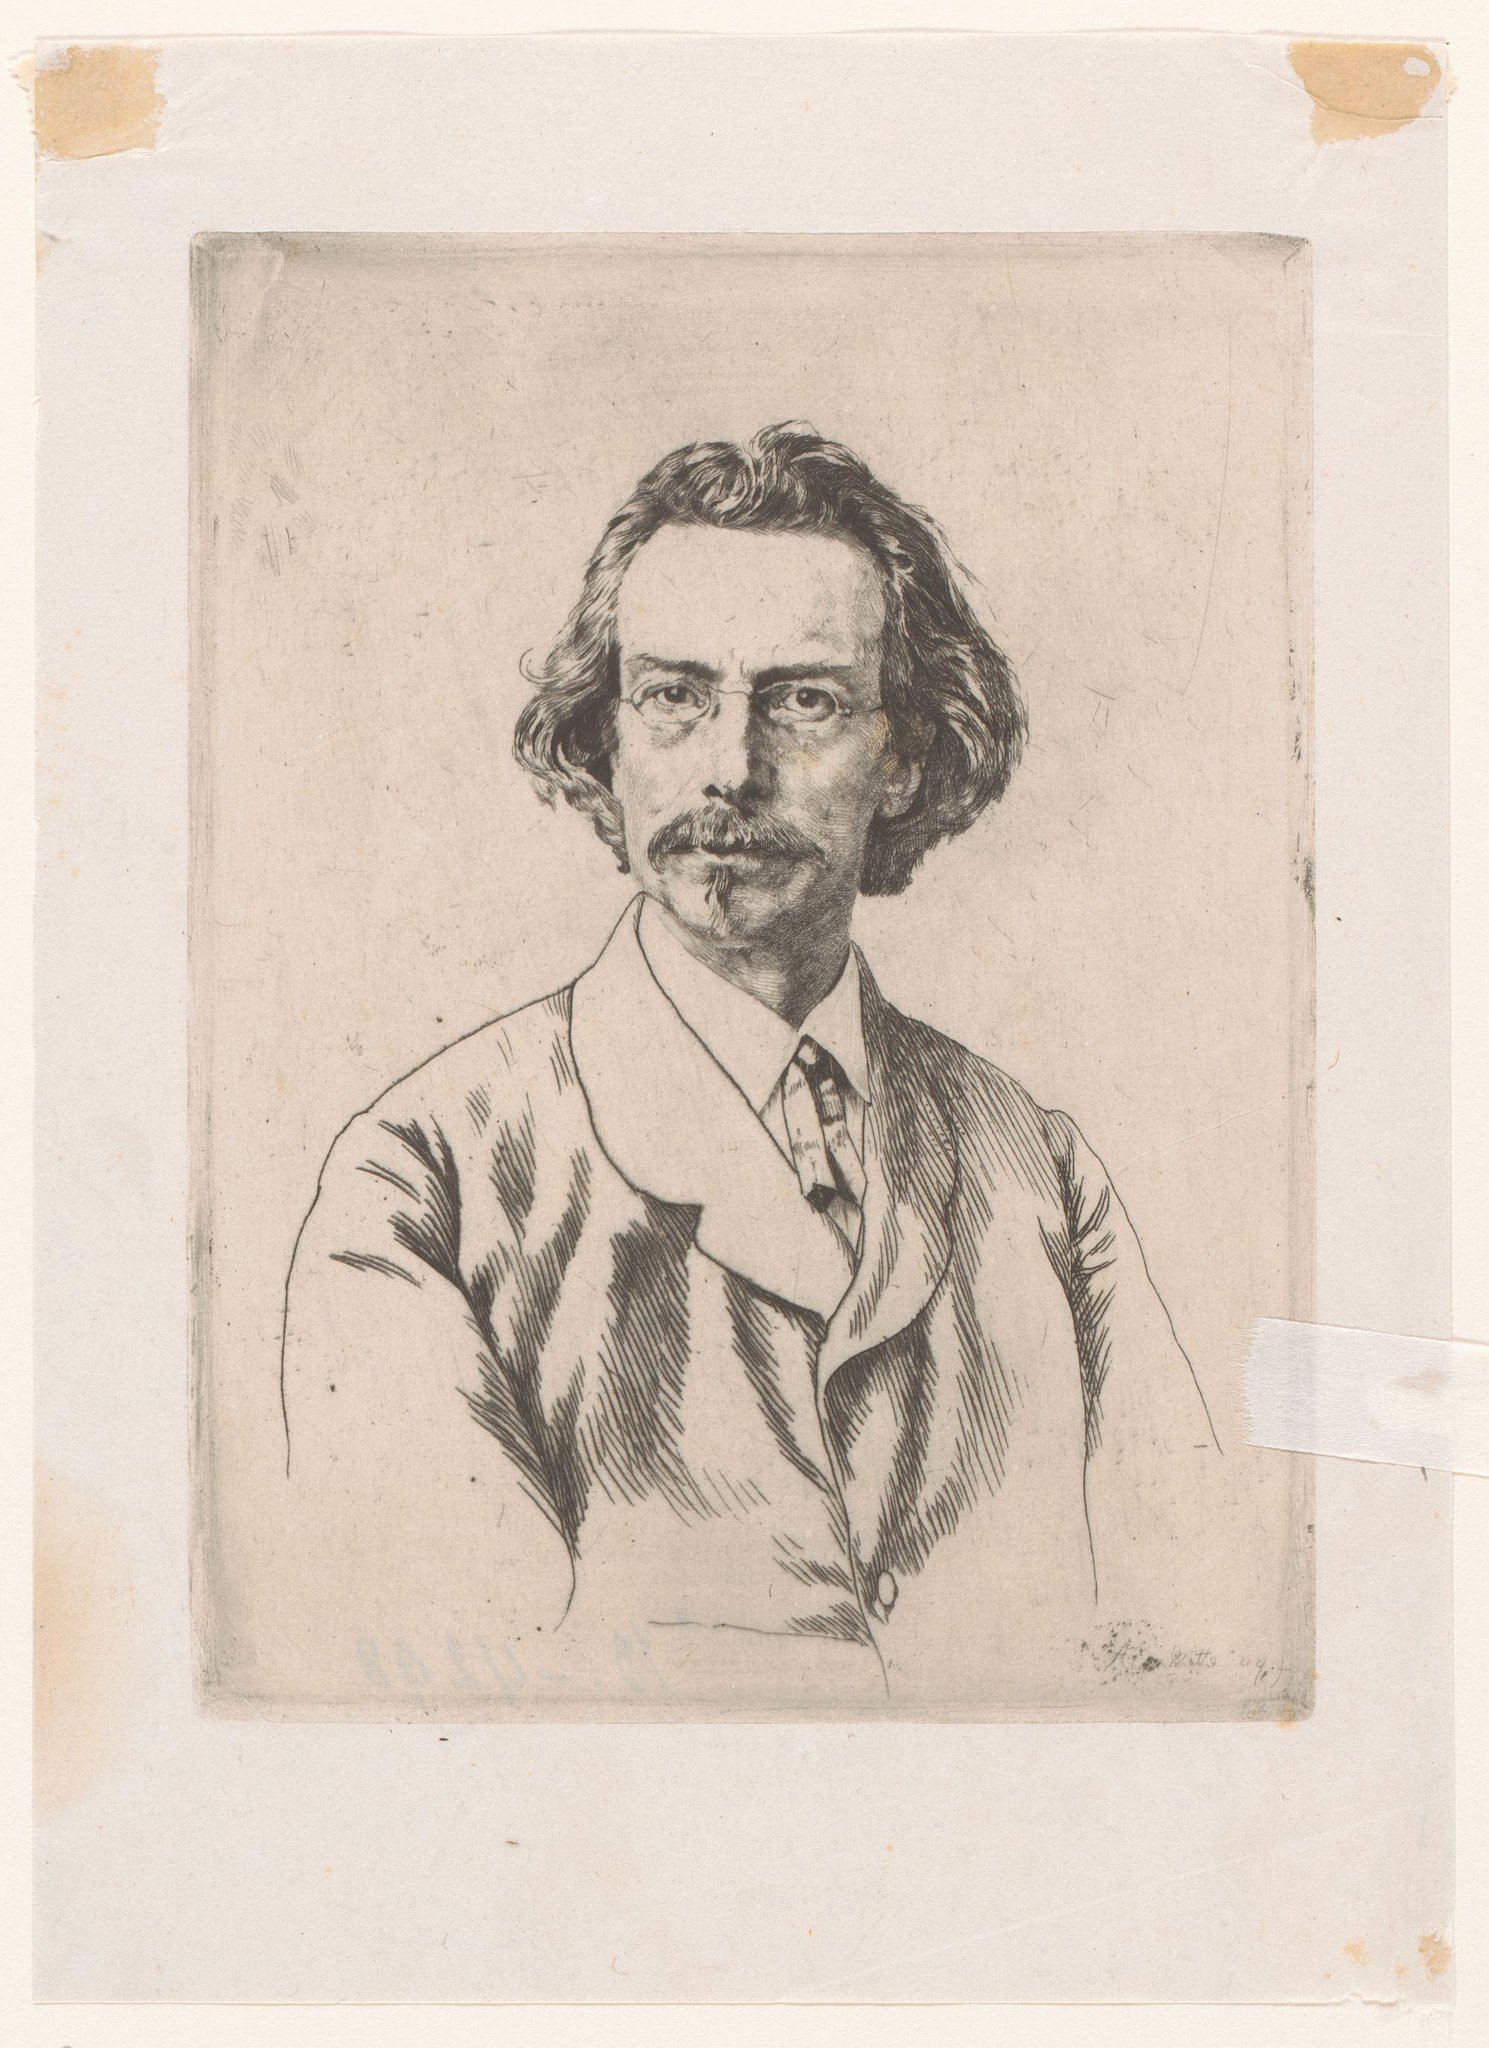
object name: print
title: Portret van Léonard Terry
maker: adrien de witte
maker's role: print maker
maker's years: 1850-1935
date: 1883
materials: paper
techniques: etching, retroussage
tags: eyeglasses, spectacles, moustache, adult man, historical persons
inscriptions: collector's mark: Lugt 2228